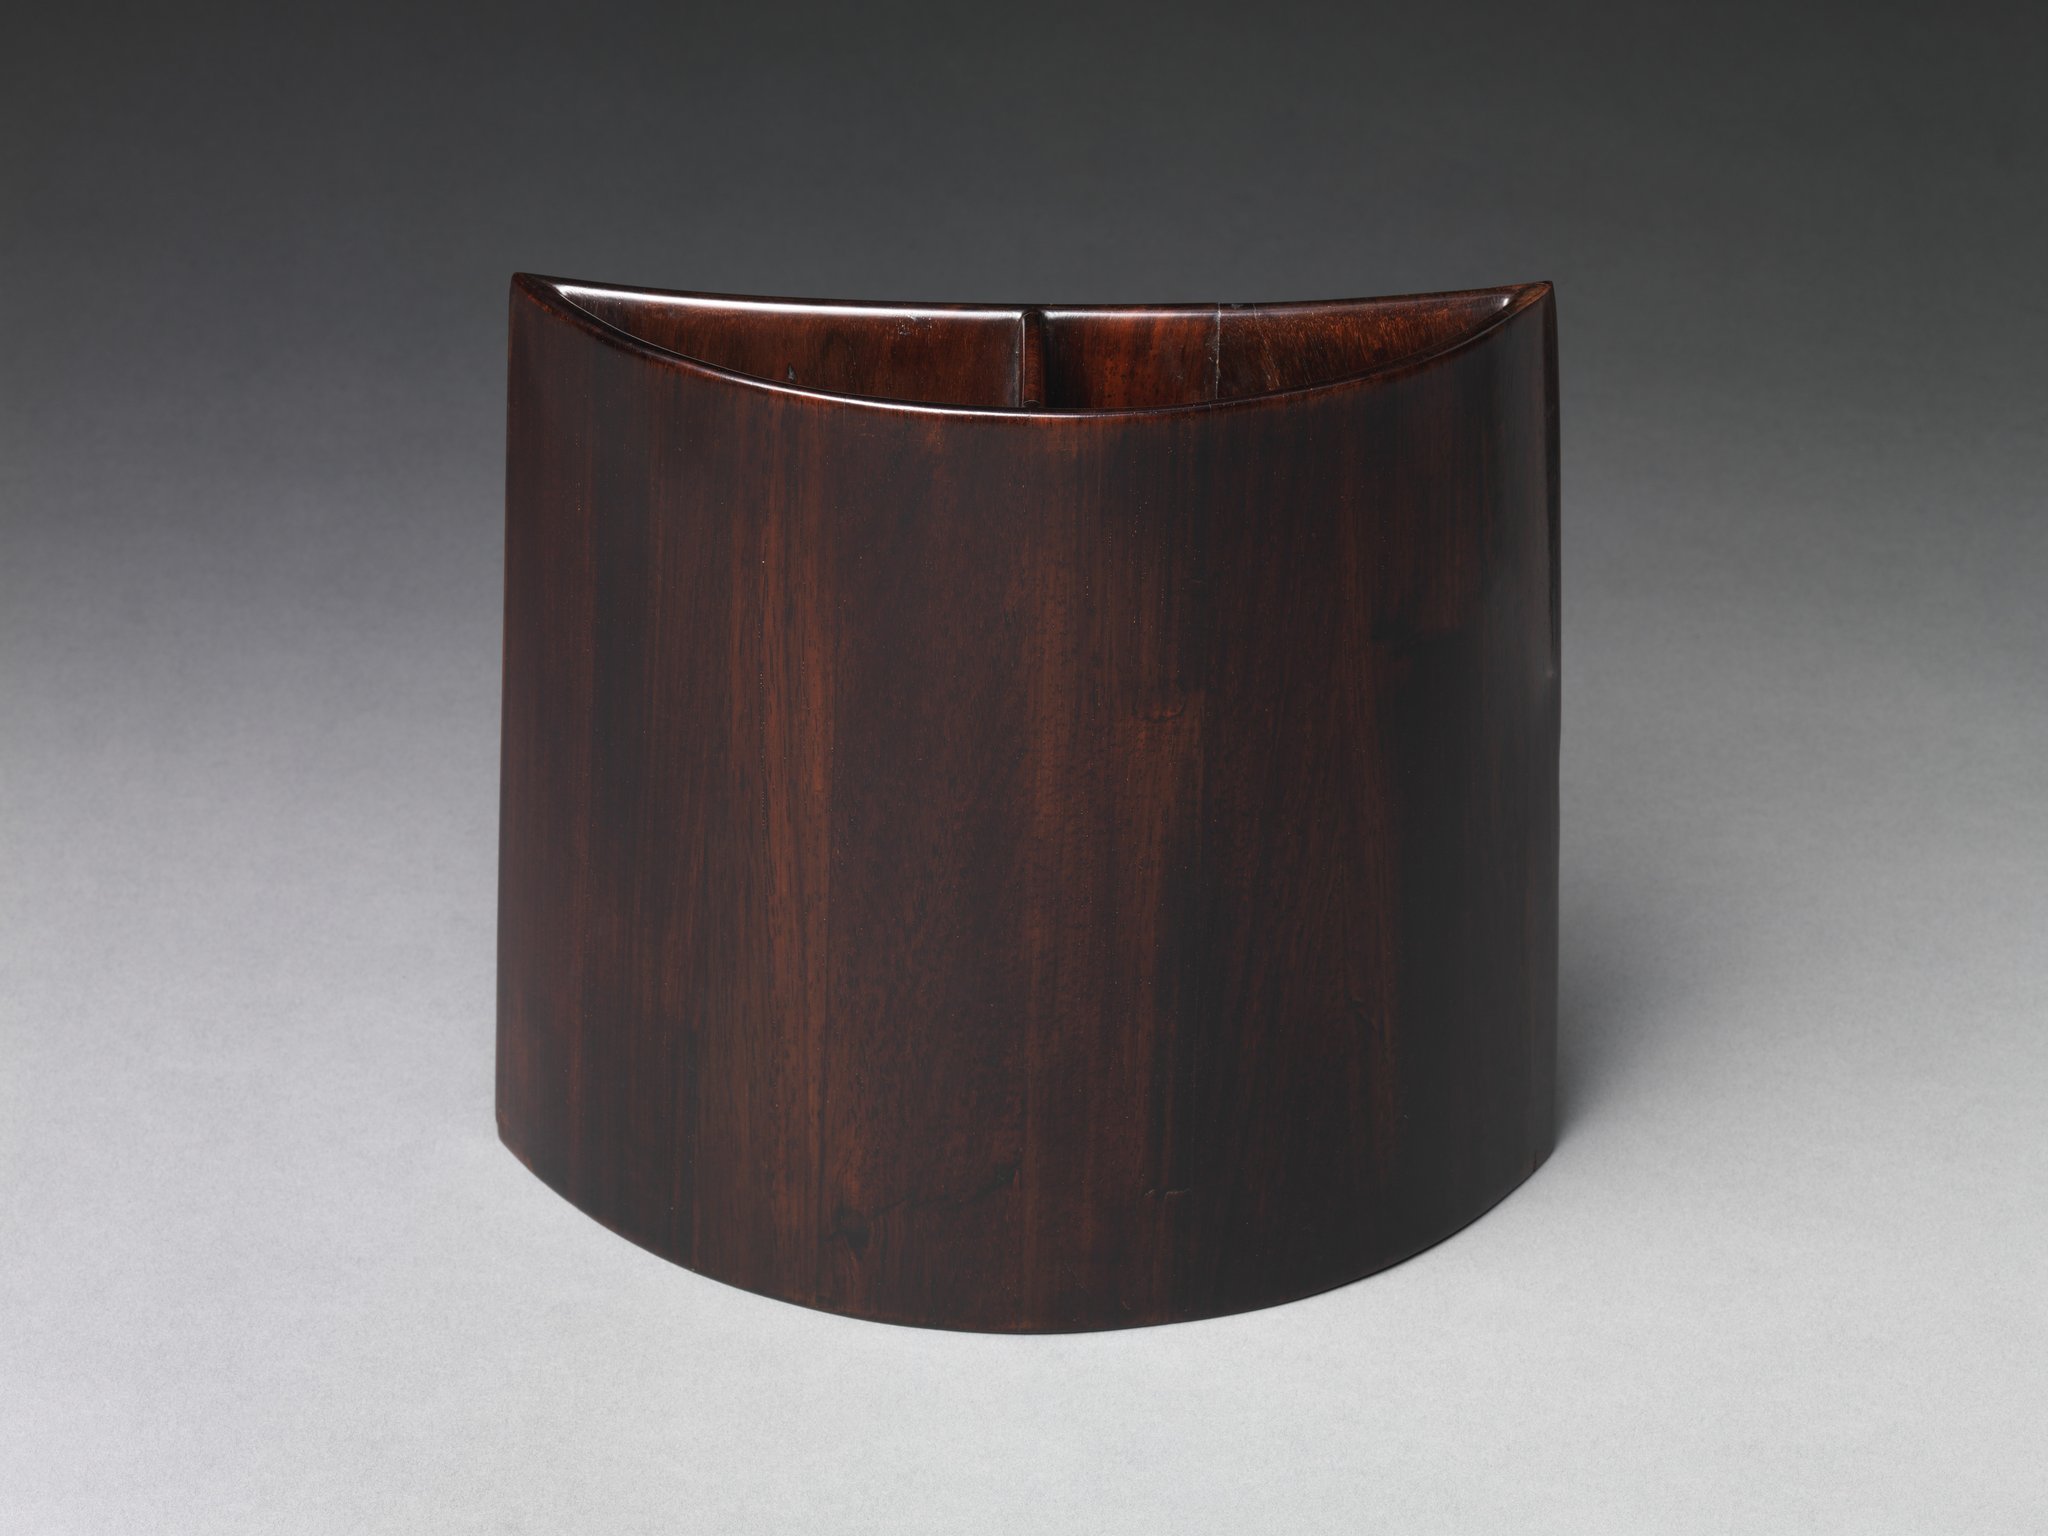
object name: brush holder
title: Half Moon Brush Holder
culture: chinese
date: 1700